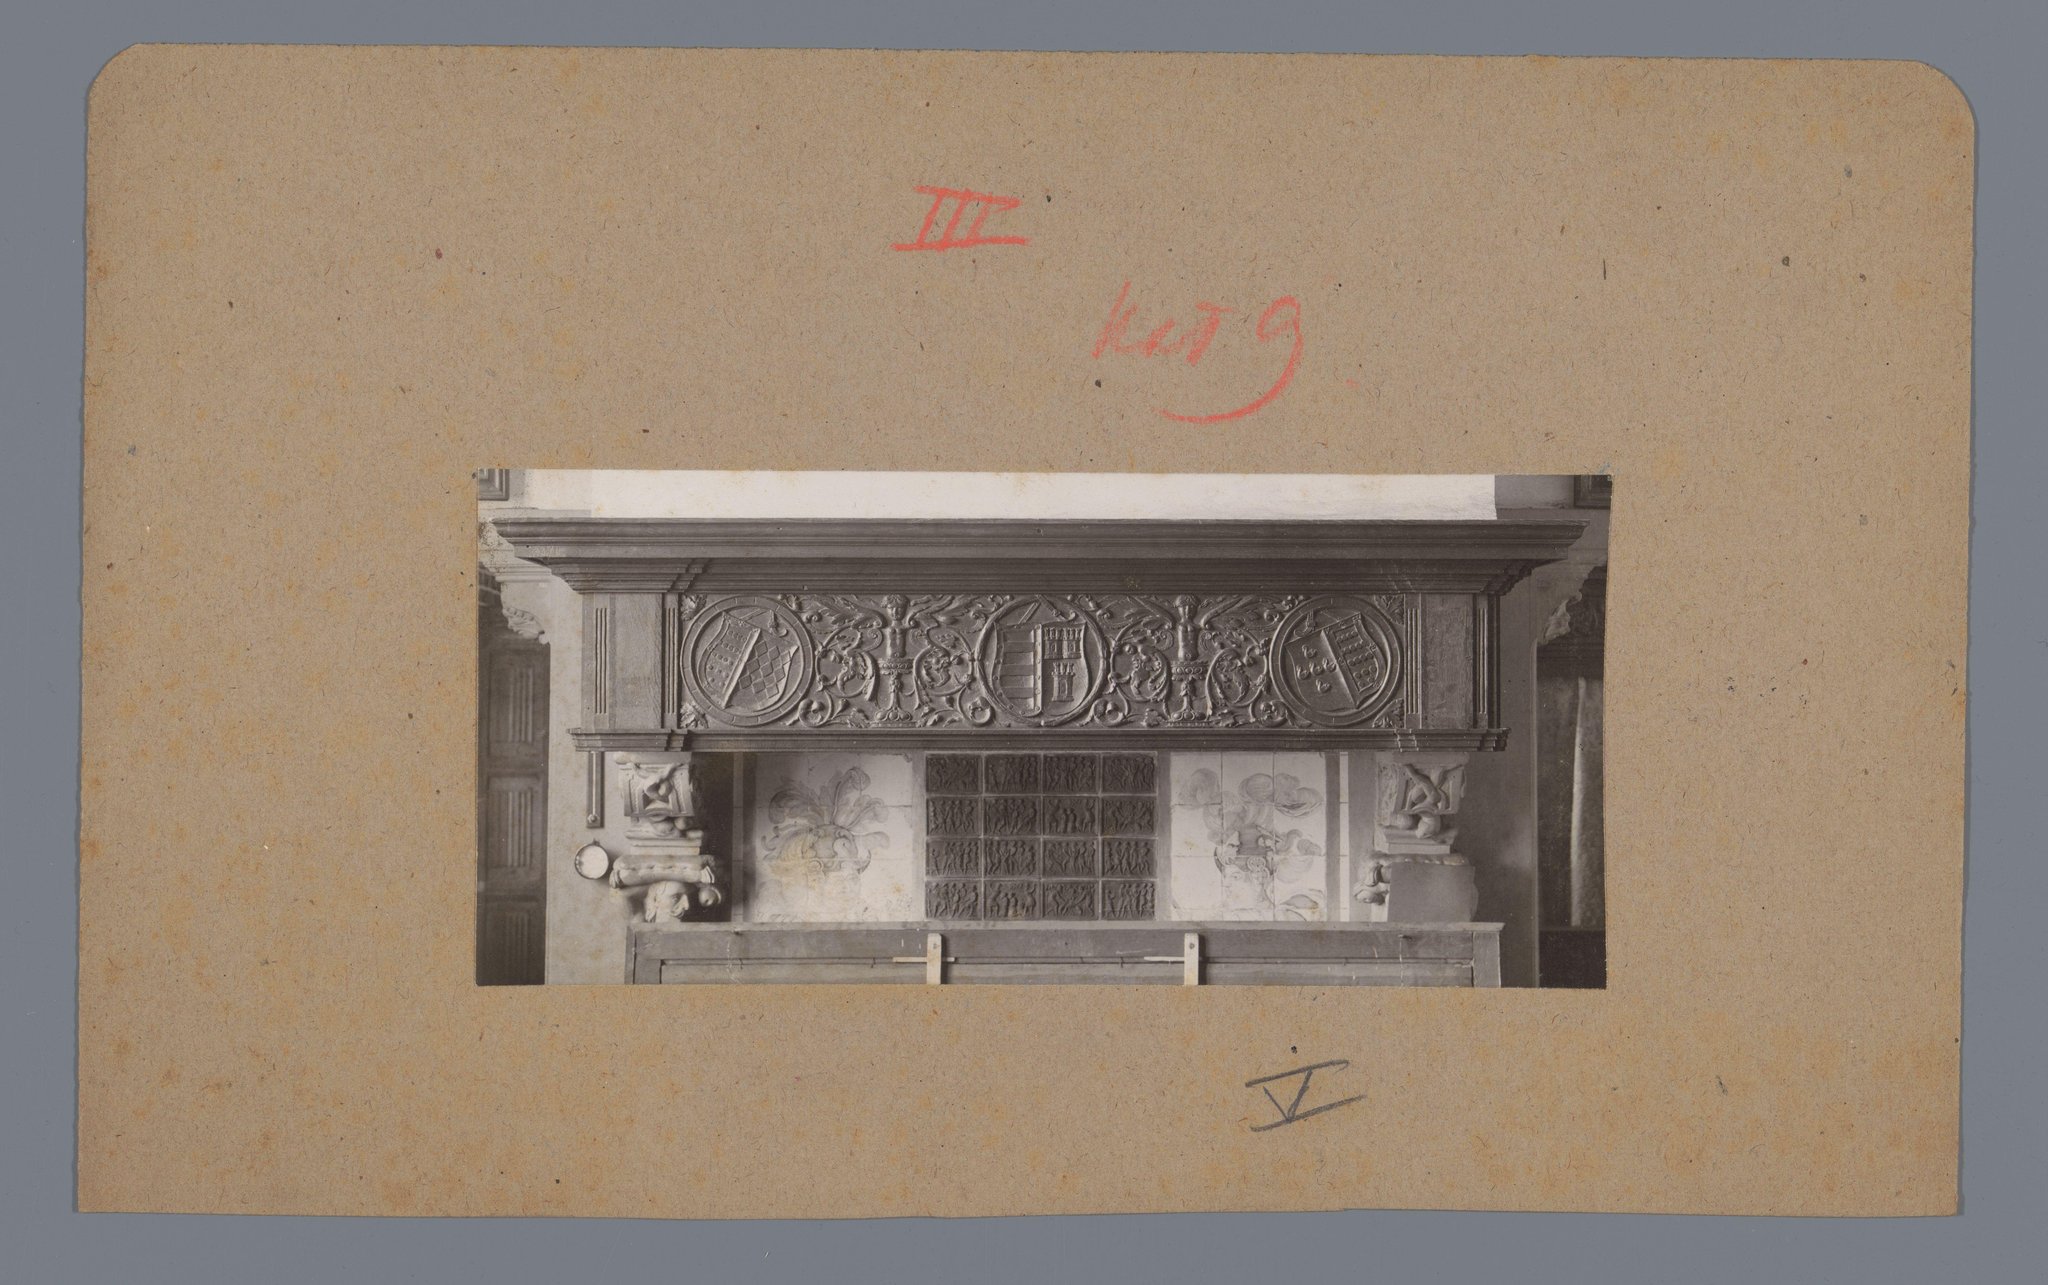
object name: photograph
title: Schouw gedecoreerd met wapenschilden in het Rijksmuseum te Amsterdam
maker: Anonymous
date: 1875-1900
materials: photographic support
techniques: matte daylight collodion silver print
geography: amsterdam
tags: coat of arms (as symbol of the state, etc.), open hearth, fire-place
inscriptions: collector's mark: ‘Kunstnijverheidschool Quellinus Amsterdam Frans Halsstraat 14.’, number: ‘III Kat 9 V’, collector's mark: ‘Instituut voor kunst-nijverheidsonderwijs Gabriël Metsustraat No. 16, Amsterdam’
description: Schoorsteenfries met drie wapenschilden waaronder vermoedelijk die van Egbert van Groenenberch en Mechtelt van Rodenburch. In de schouw de tegeltableaus BK-NM-5290 en BK-NM-5291.